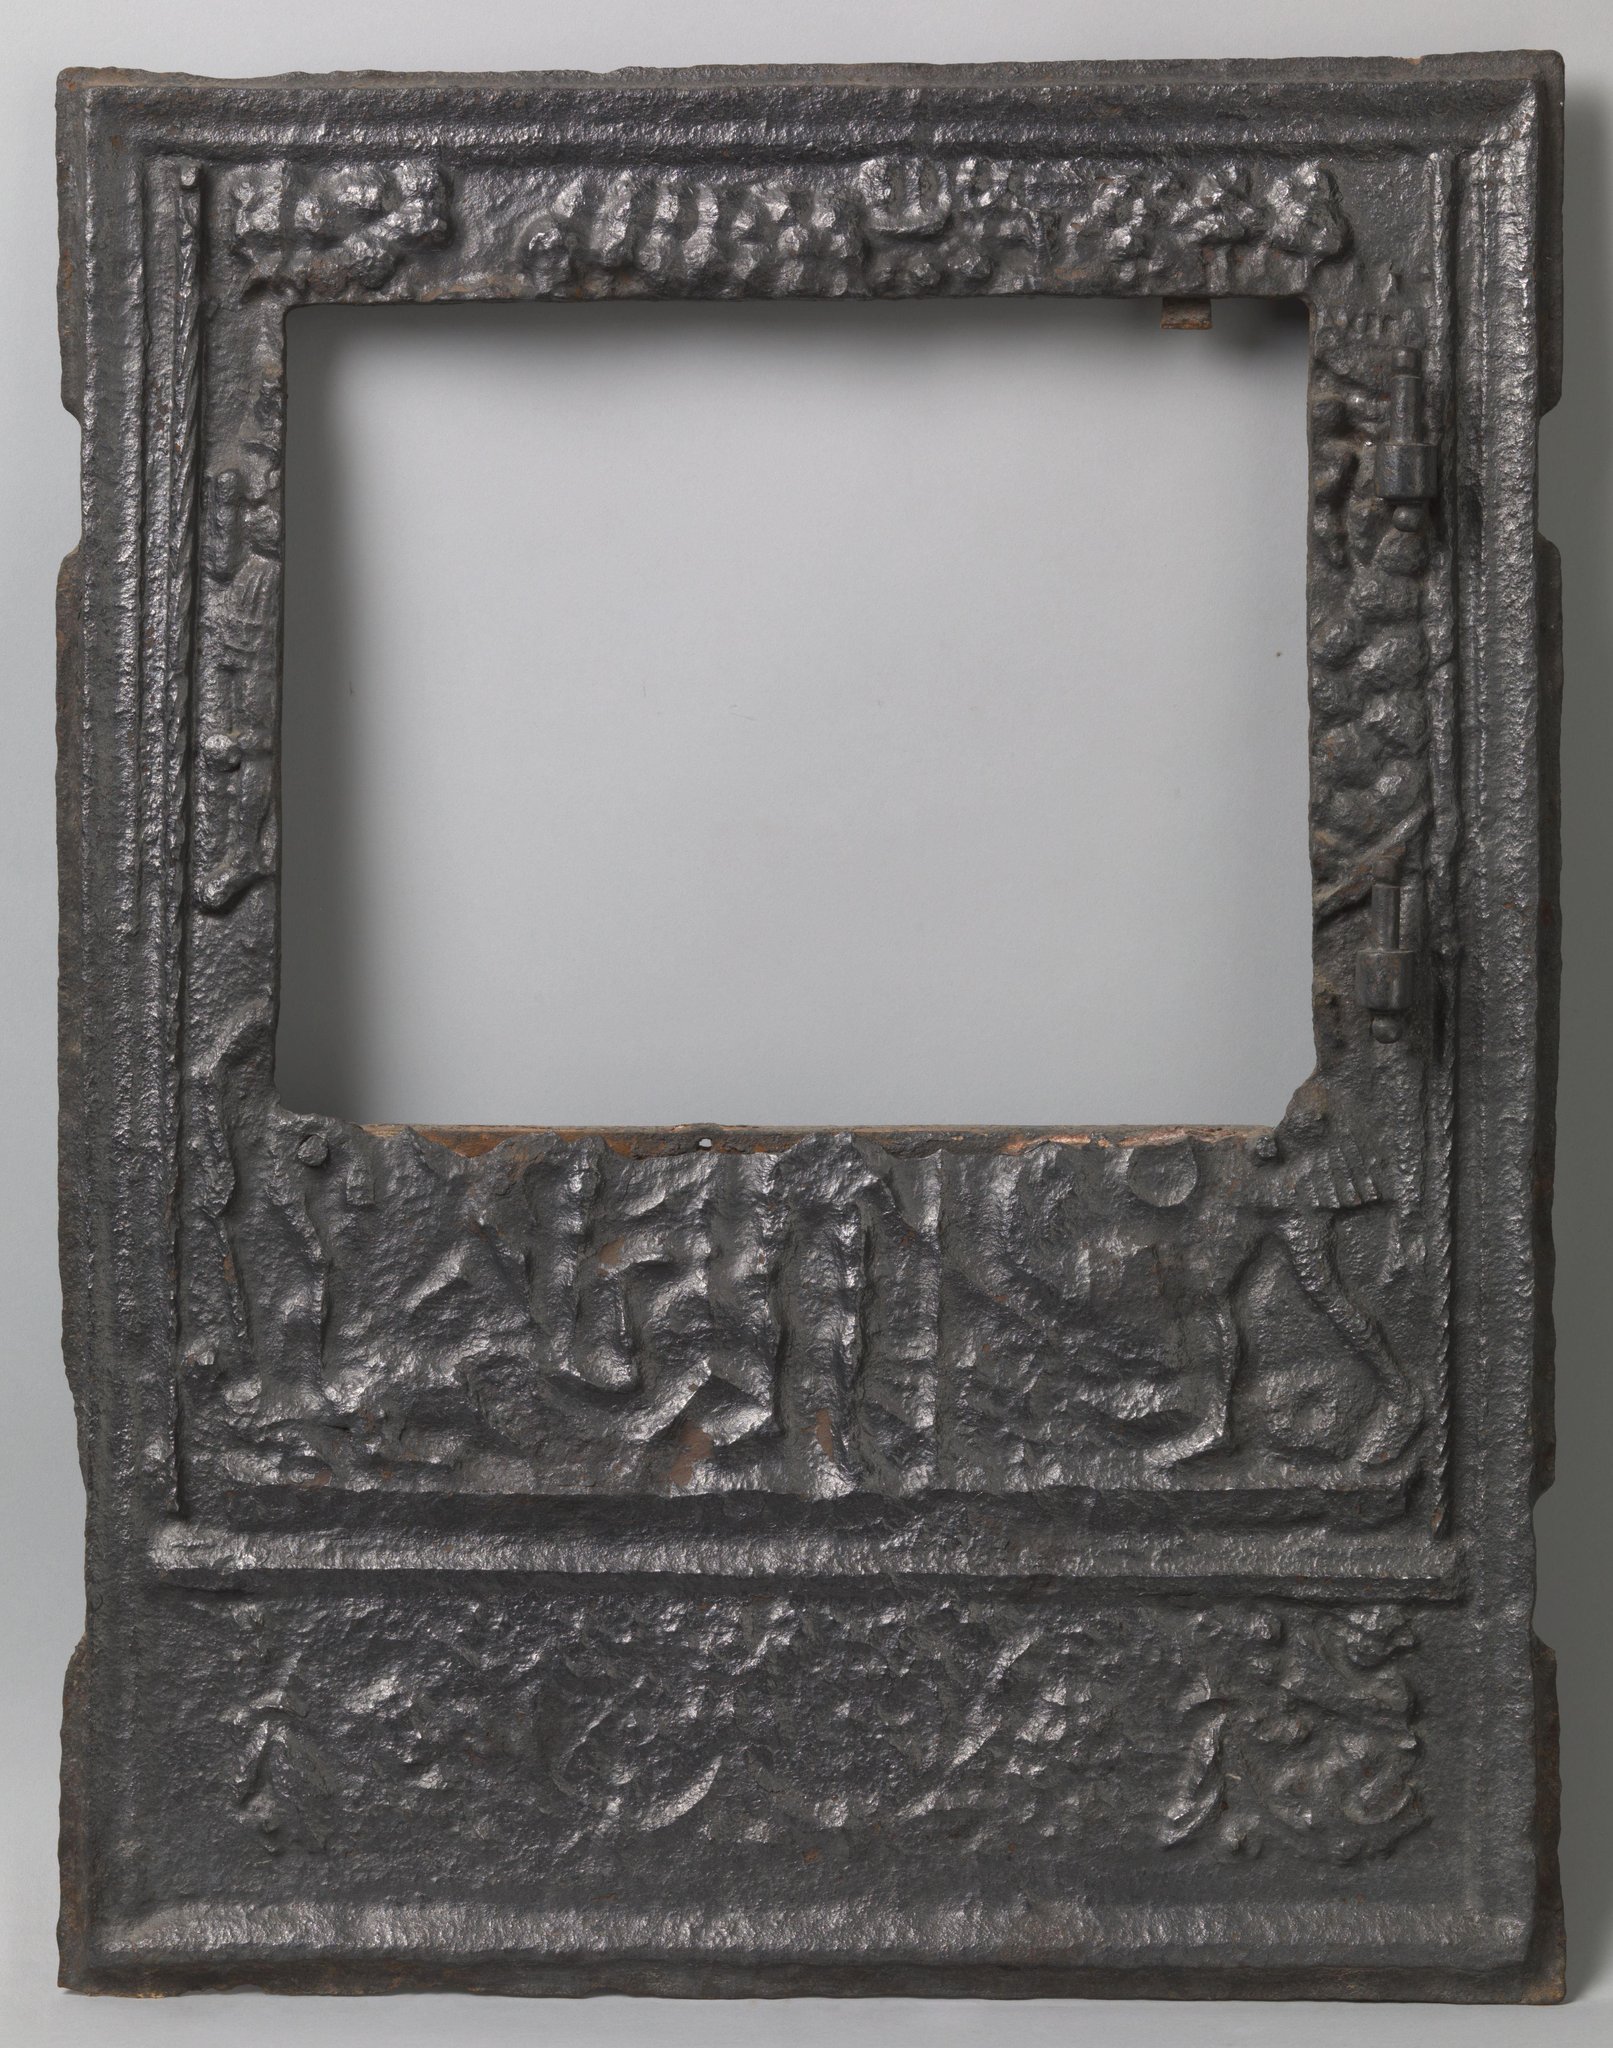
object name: stove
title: Kachelplaat met Slag bij Gibeon en opening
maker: Anonymous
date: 1660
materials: copper, iron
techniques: casting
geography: germany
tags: joshua and the five kings of south canaan (joshua 10:1-27)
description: Kachelplaat van gietijzer, bestaande uit twee zones. Centraal in de bovenste zone staat de Slag bij Gibeon (Jozua 10: 1-27). Op de voorgrond staan vier gewapende mannen in harnas rond een op de grond gelegen man. Op de achtergrond wordt rechts een man een grot in geleid en links is een man opgehangen aan een boom. De onderste zone is versierd met krullend rankwerk. De plaat heeft bovenin een opening.